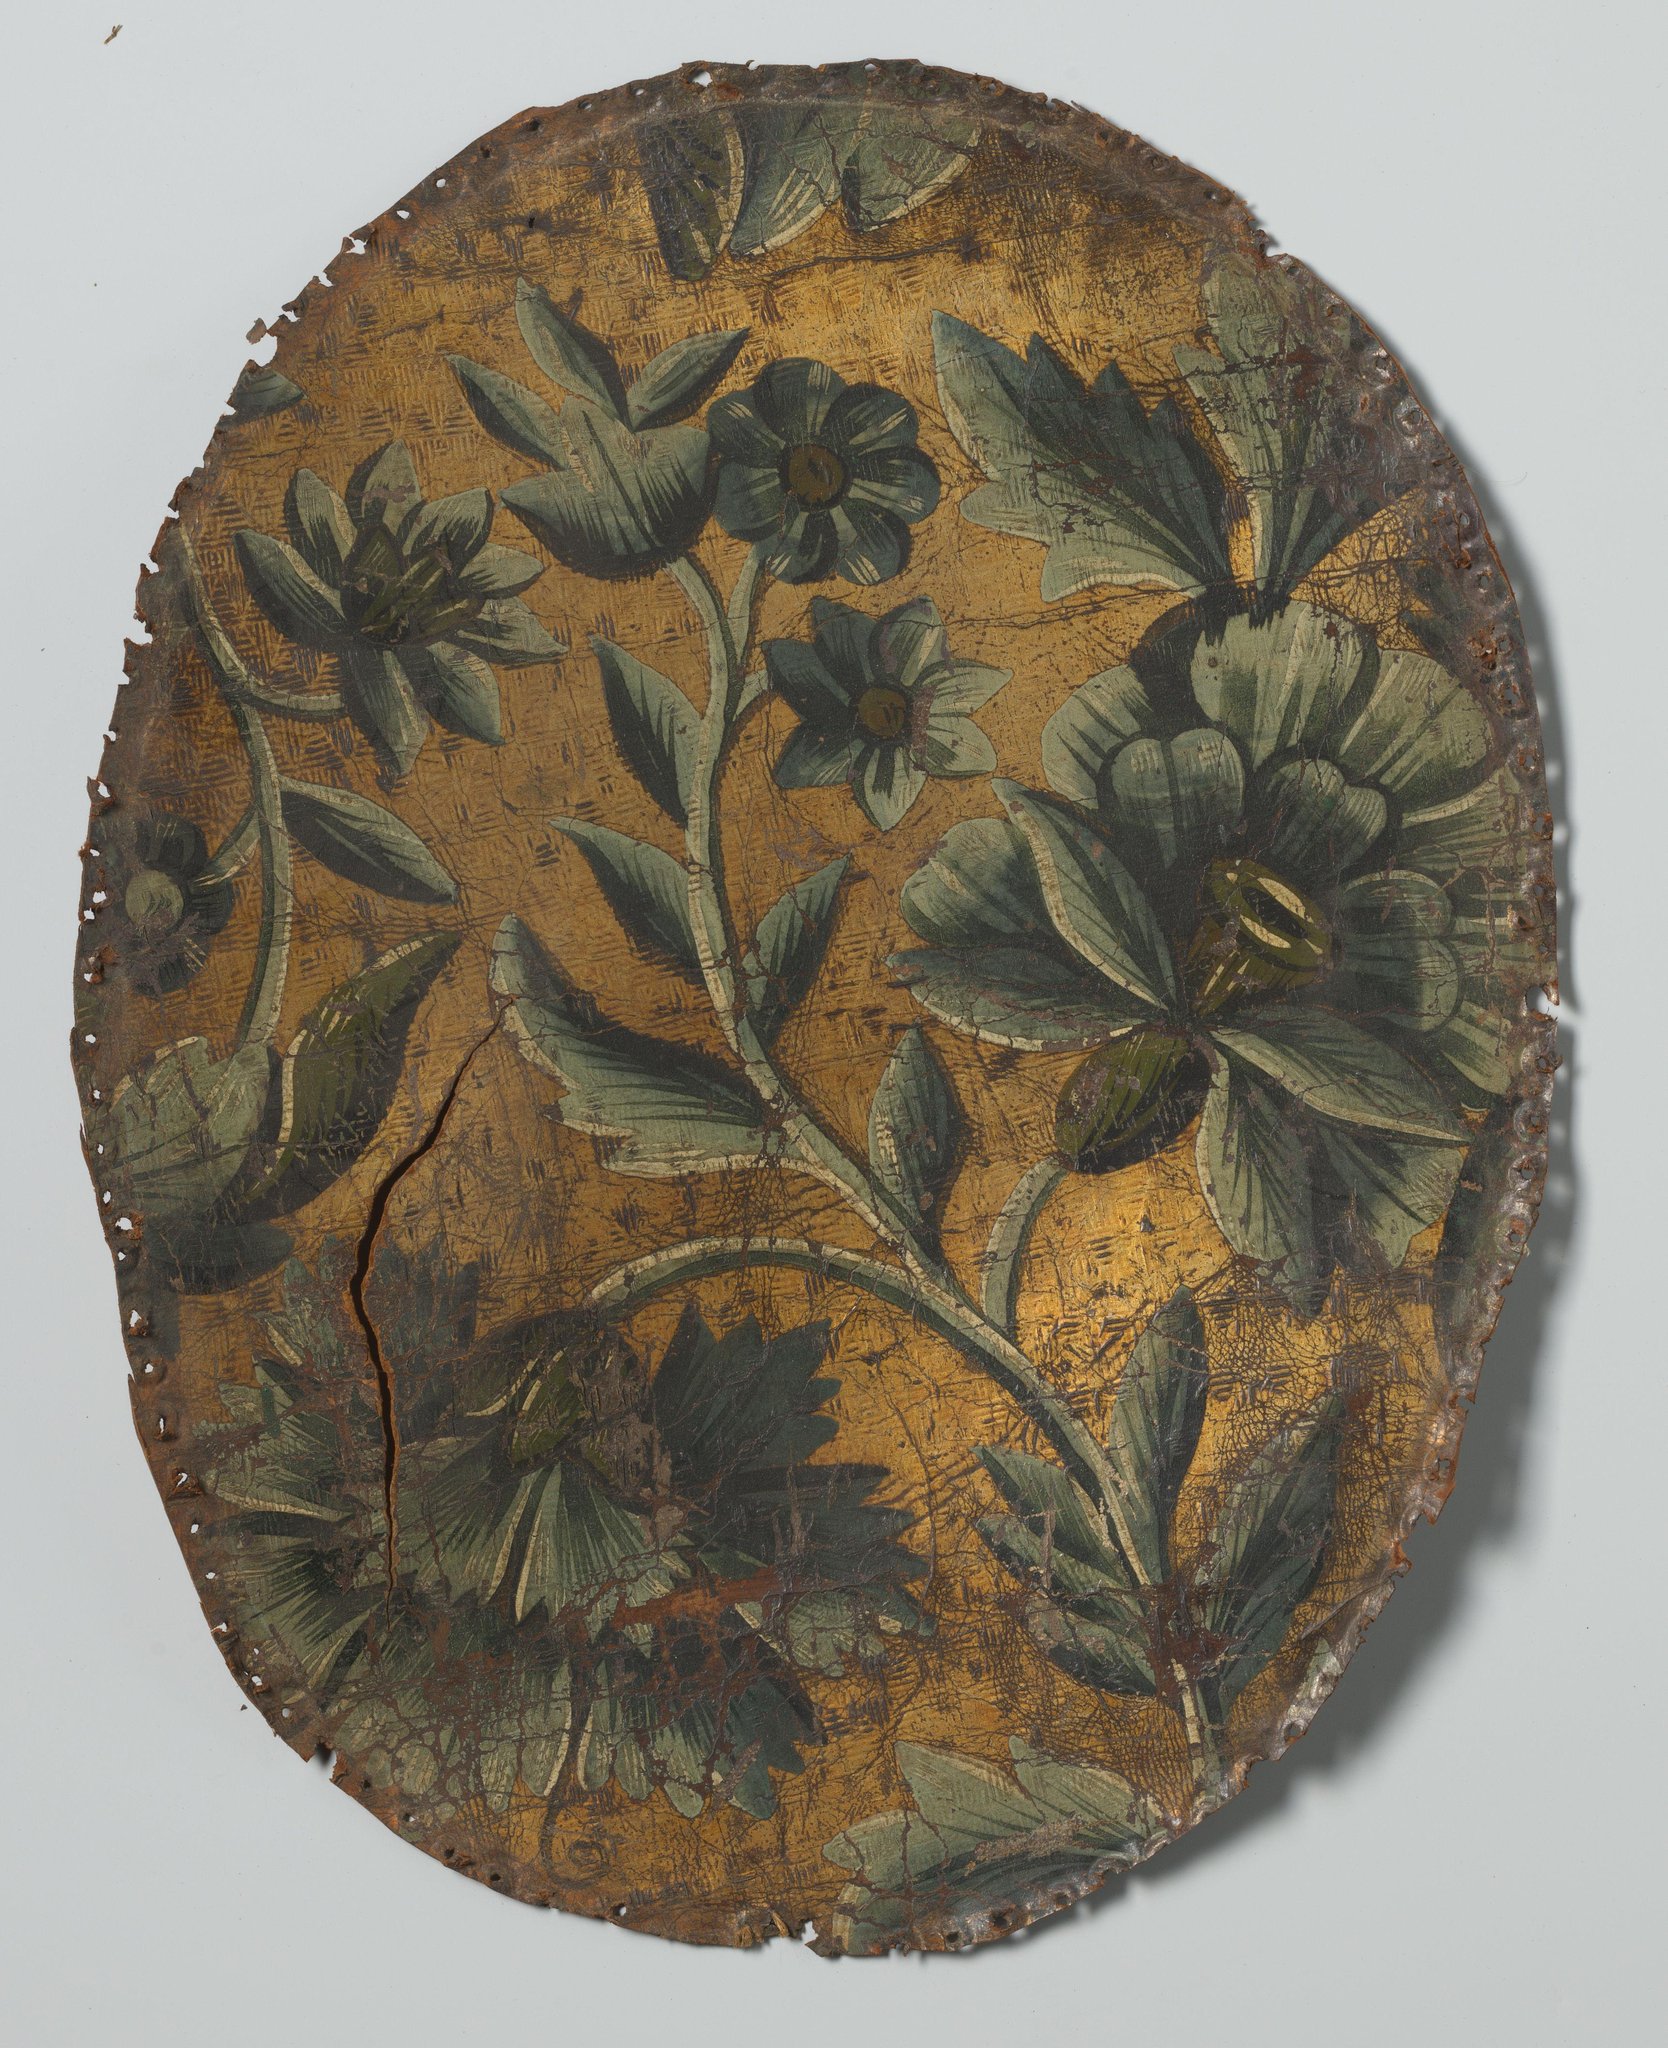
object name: stoelbekleding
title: Rugbekleding van een stoel van goudleer met patroon van bloemen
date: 1700-1800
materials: gilt leather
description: Rugbekleding van een stoel van goudleer met patroon van bloemen.